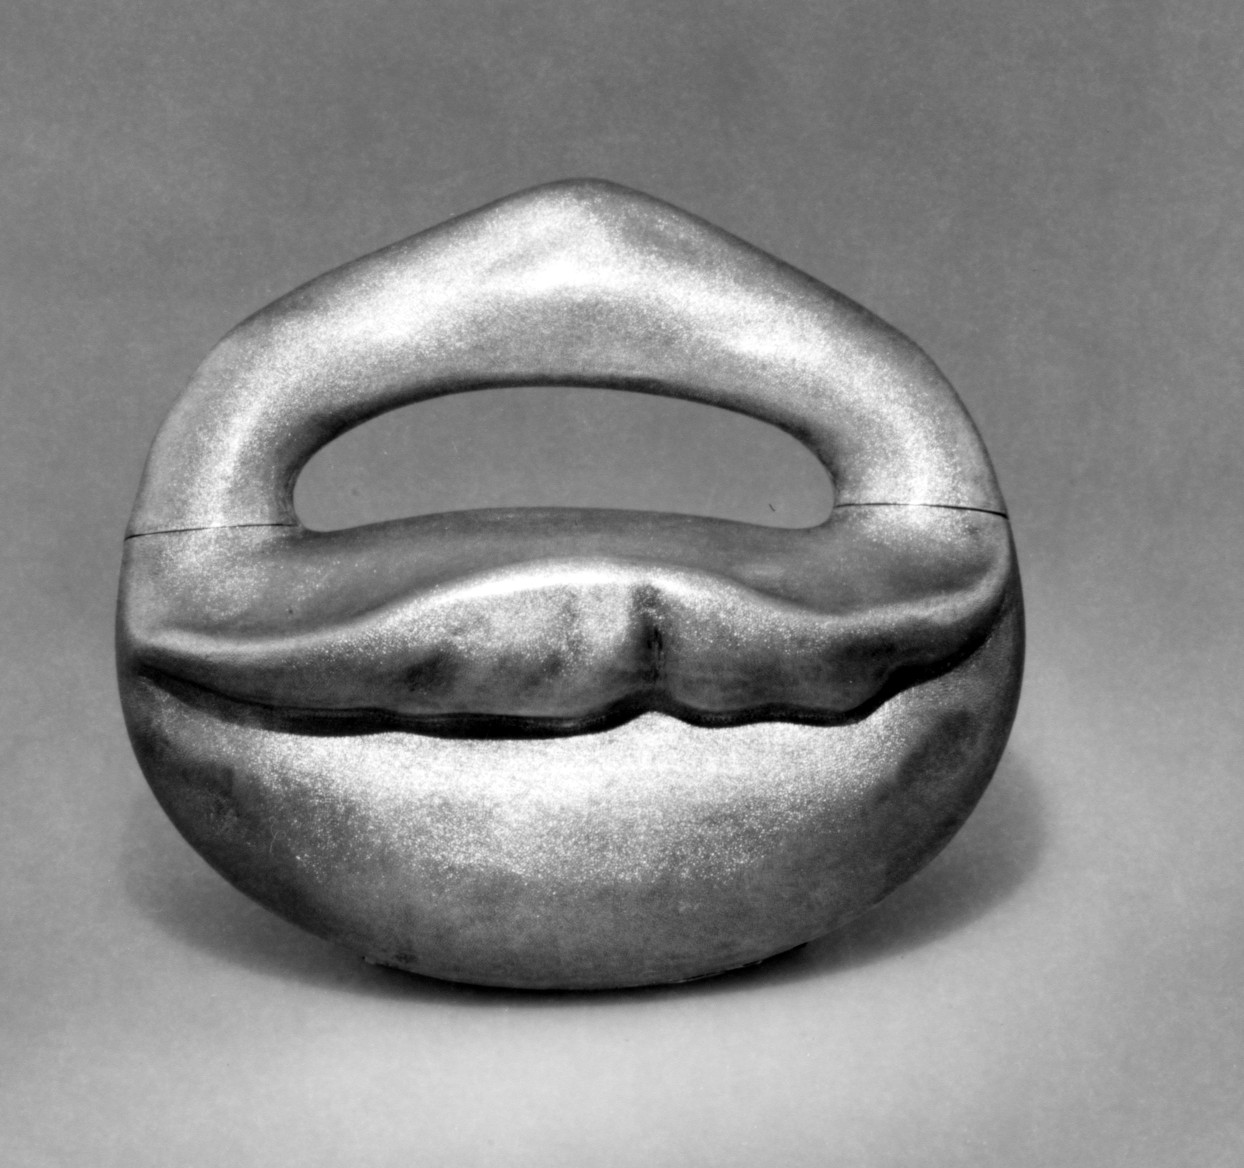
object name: salt with cover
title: Salt with hinged cover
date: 1894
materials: silver gilt